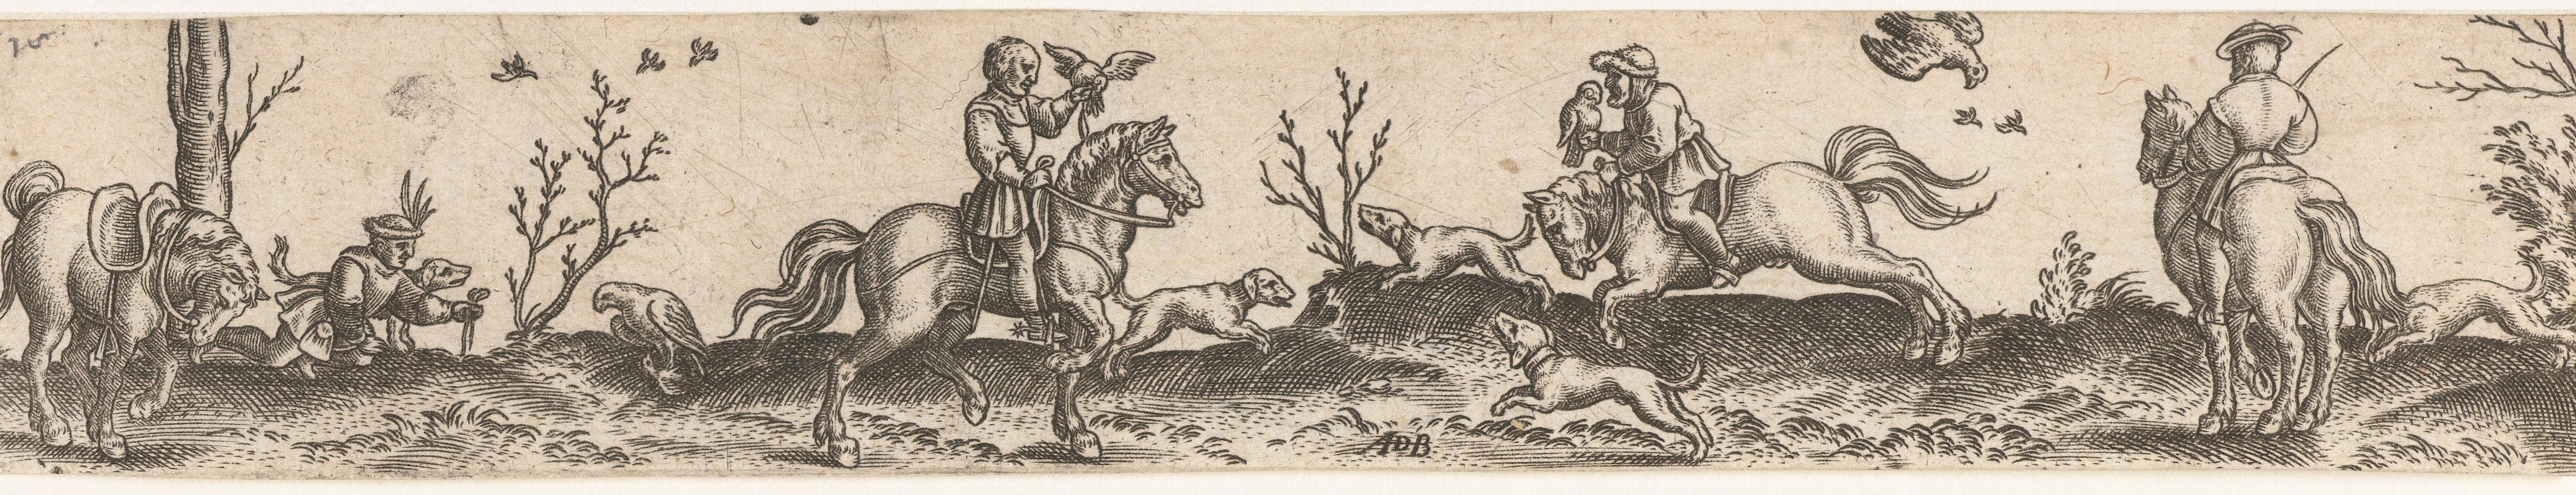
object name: print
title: Valkenjacht.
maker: abraham de bruyn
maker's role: print maker, publisher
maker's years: 1540-1587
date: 1565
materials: paper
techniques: engraving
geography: antwerp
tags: predatory birds: falcon, hunting dogs, sports, games ~ animals (+ hunting with falcon, hawk; falconry), sports, games ~ animals (+ hunting with dogs)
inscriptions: collector's mark: Lugt 2228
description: Vier ruiters op valkenjacht. Twee valkeniers rijden met een valk in de hand naar elkaar toe. Rechts staat een ruiter naar de jacht van zijn valk te kijken. Links is een jager van zijn paard gestegen om zijn valk te grijpen. Jachthonden rennen heen en weer.